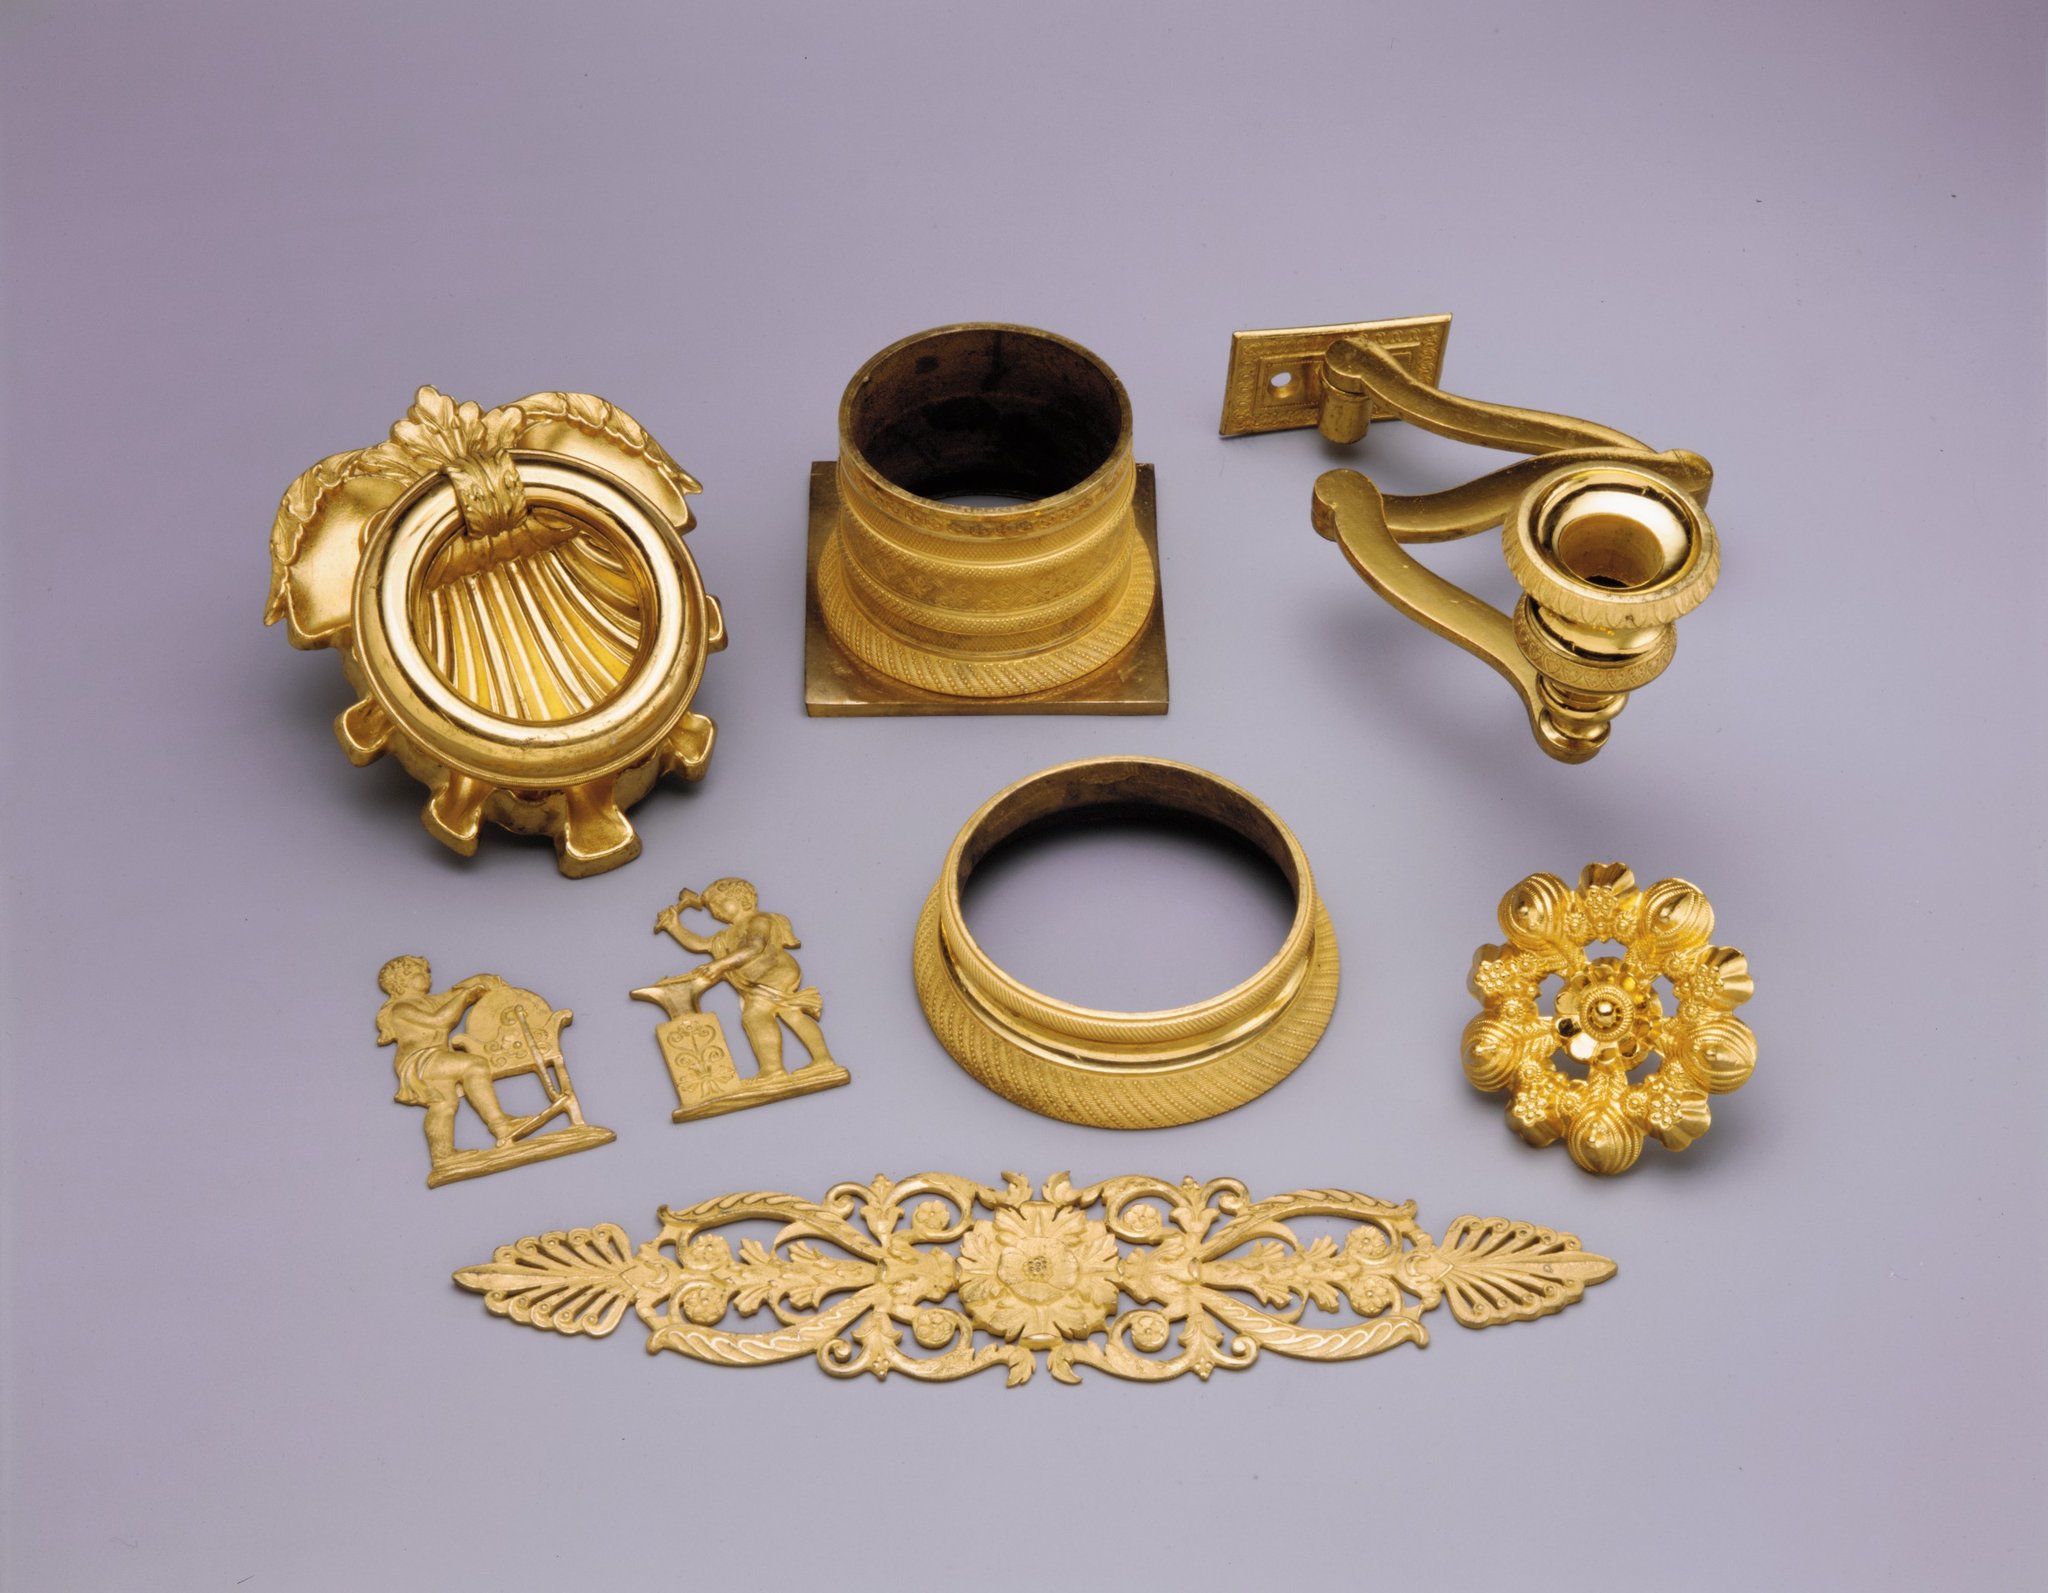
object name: furniture hardware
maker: henry kellam hancock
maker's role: retailer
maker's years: 1816-1851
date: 1820-1830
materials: brass, gilt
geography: france